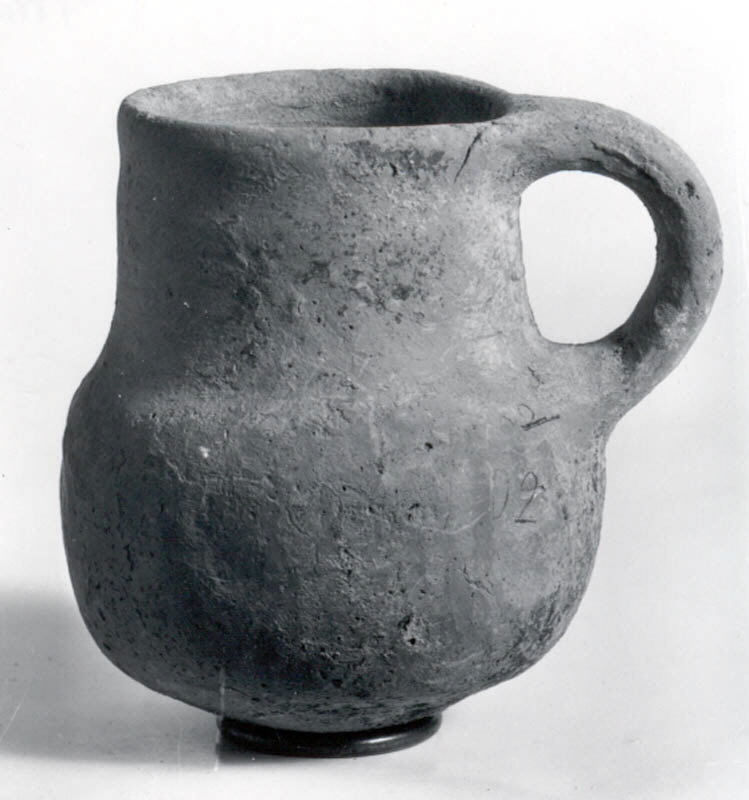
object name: jug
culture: israelite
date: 734-601 BCE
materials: ceramic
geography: levant